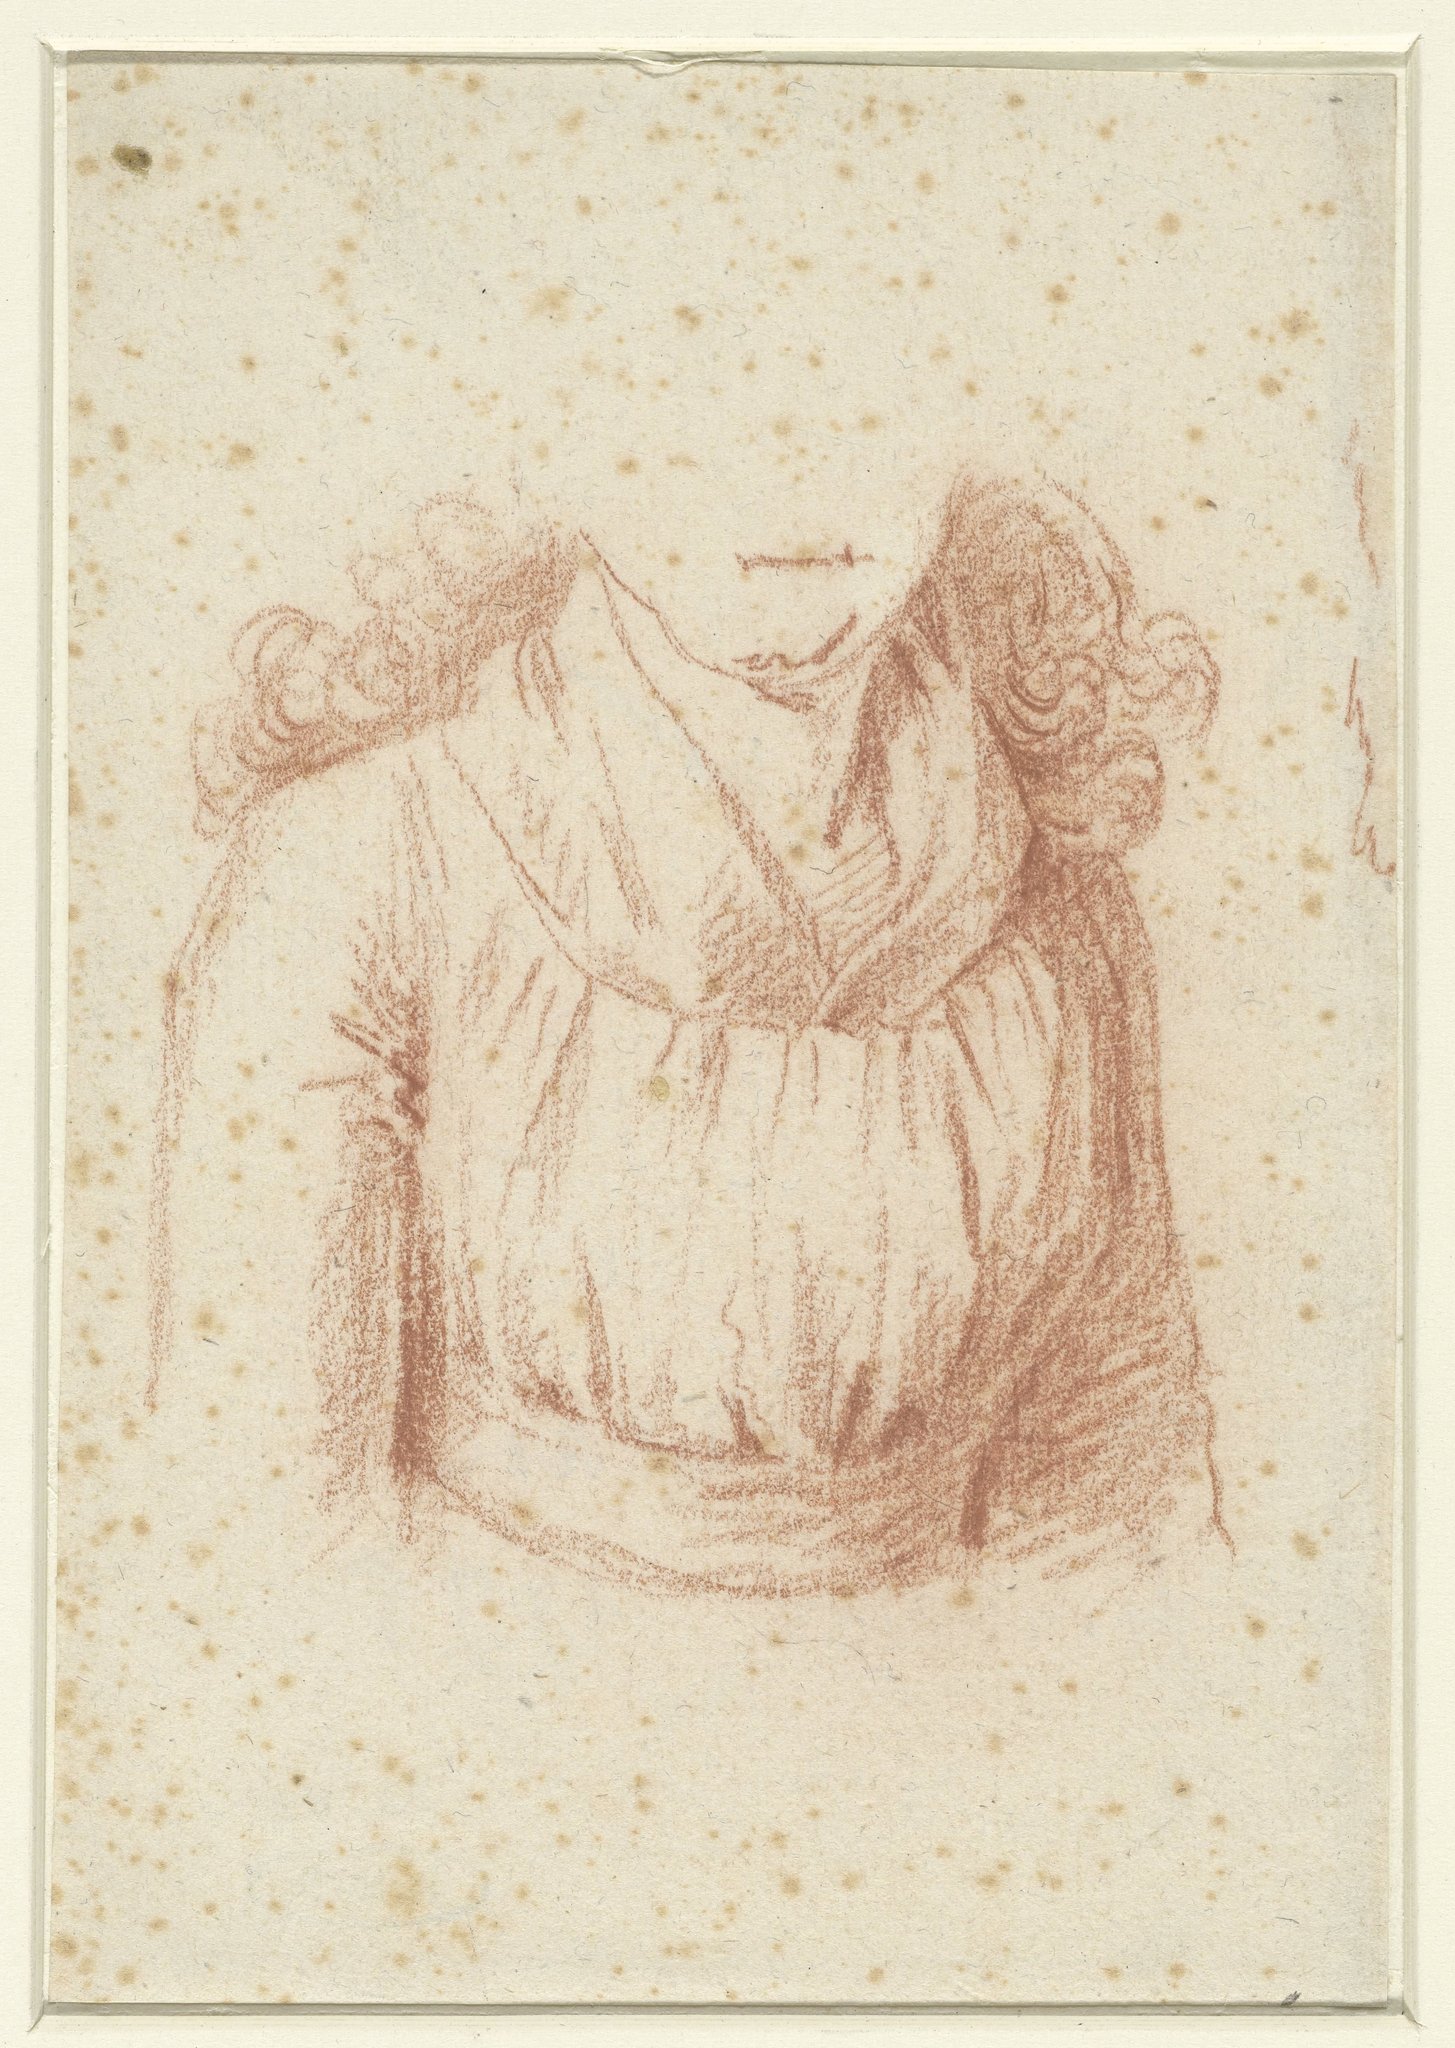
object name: drawing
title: Kostuumstudie voor een portret van Madame Molet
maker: Anonymous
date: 1795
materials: chalk, paper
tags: historical persons - bb - woman, chest, bust - aa - female human figure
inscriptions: collector's mark, verso, on the passepartout, lower right: Lugt 2760, annotation, pencil: ‘n. [?] Moreau’, inscription and date, red chalk: ‘Mr Moreau / frimaire 1795 / 10’, collector's mark, verso, lower right: Lugt 2228